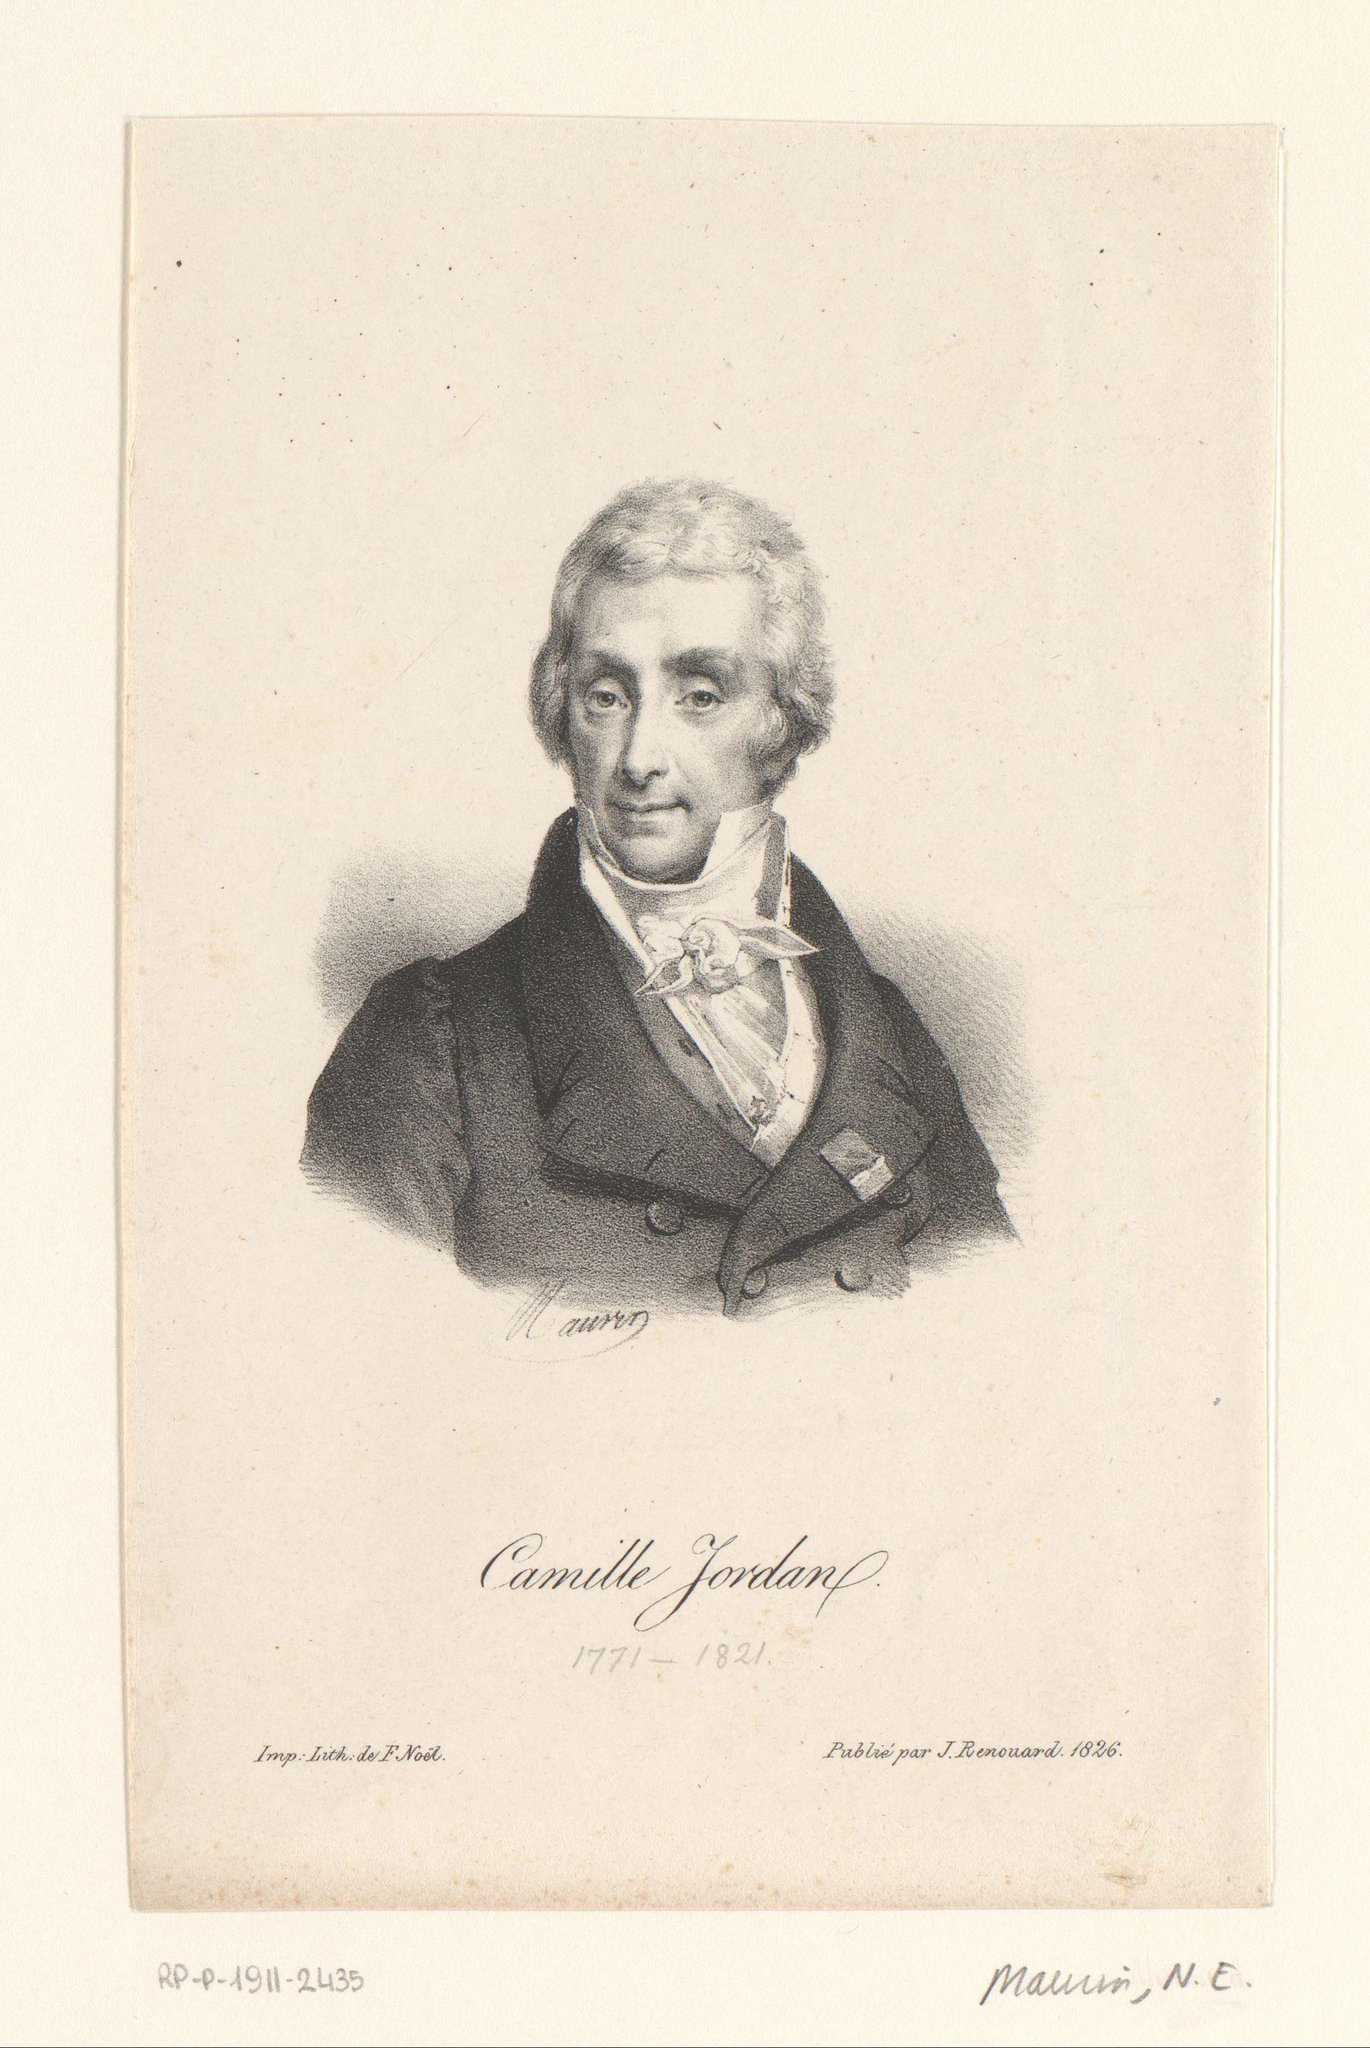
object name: print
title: Portret van Camille Jordan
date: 1826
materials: paper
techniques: lithograph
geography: paris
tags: paris, politician, historical persons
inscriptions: collector's mark: Lugt 2228